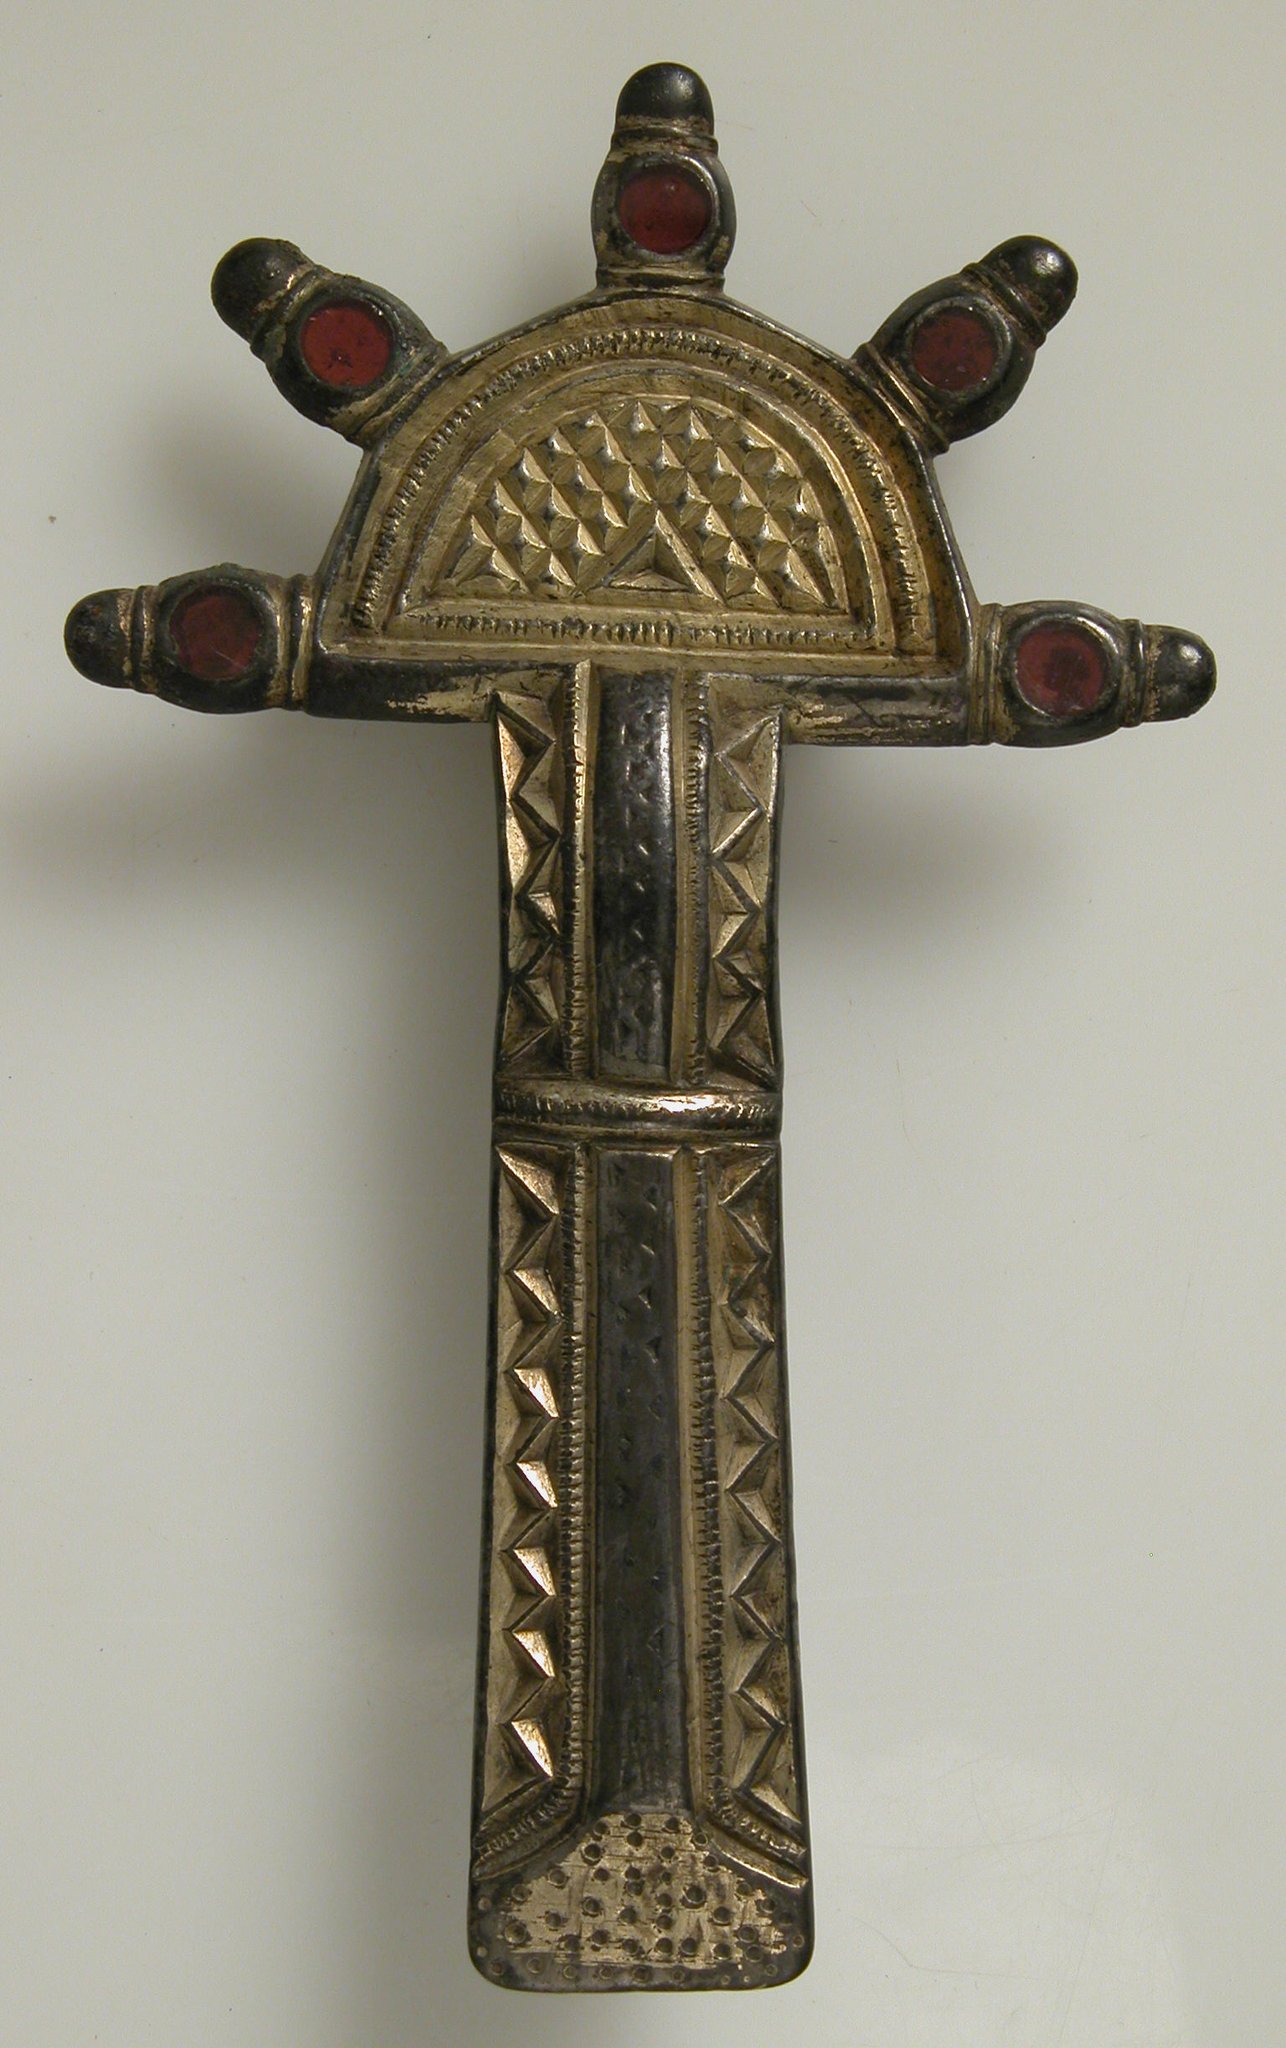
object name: brooch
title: Bow Brooch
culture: frankish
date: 534-566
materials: gemstone, iron, niello, silver gilt